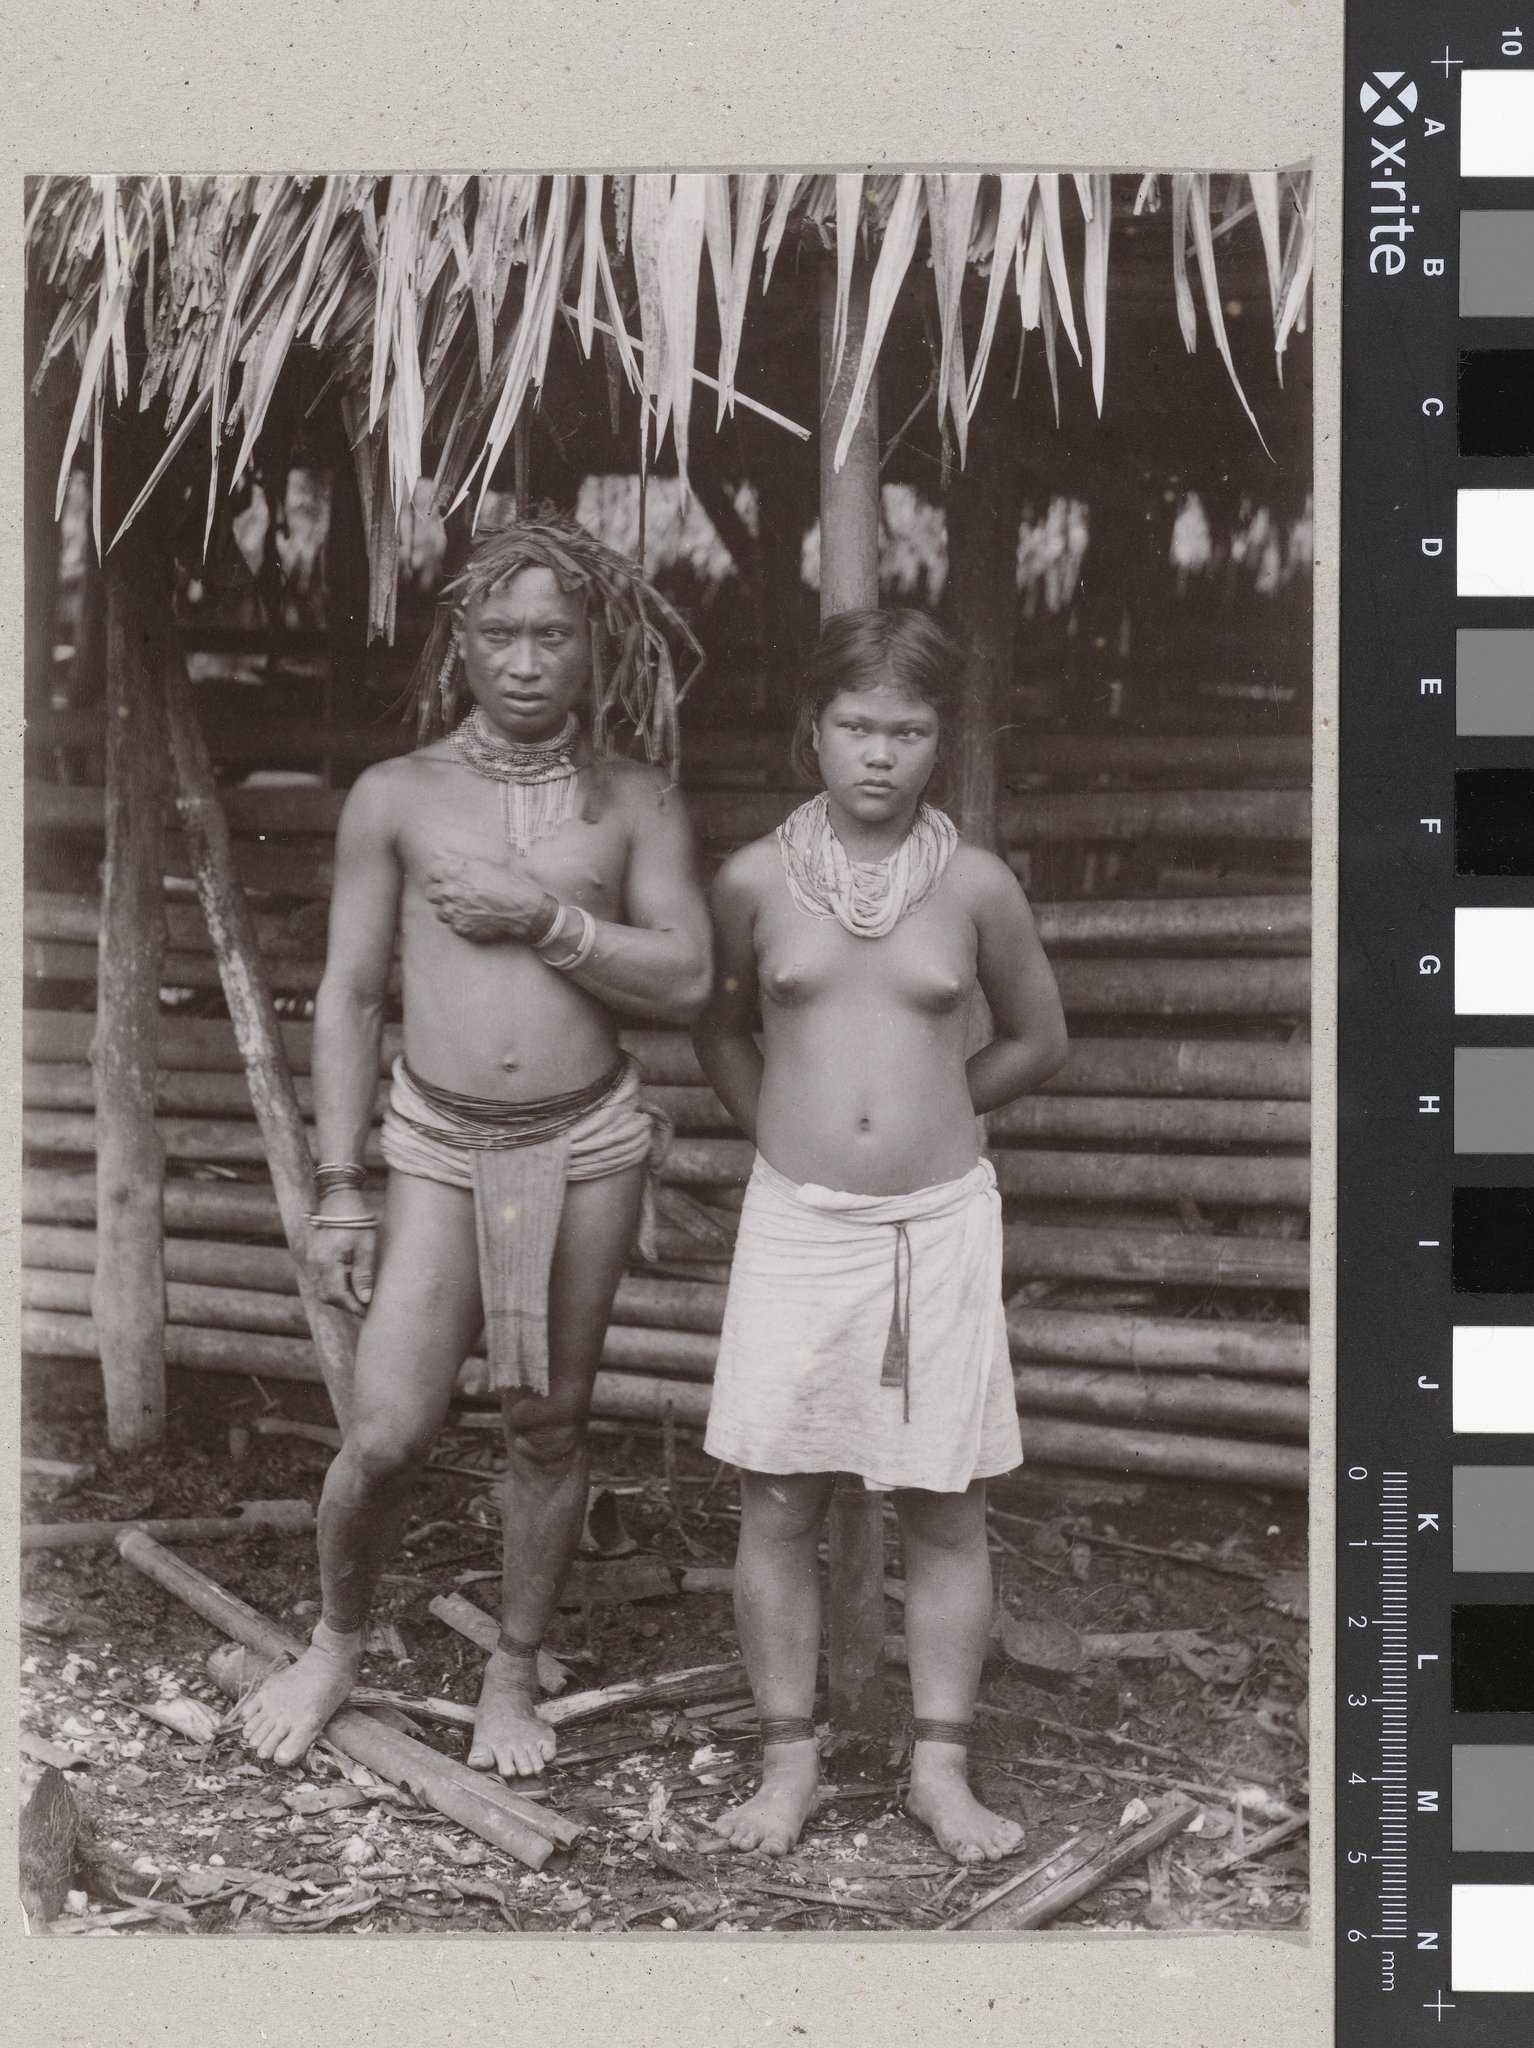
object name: photograph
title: Portret van een onbekende man en jonge vrouw op de Mentawei-eilanden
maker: christiaan benjamin nieuwenhuis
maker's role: publisher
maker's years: 1863-1922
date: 1890-1897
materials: paper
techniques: albumen print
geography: medan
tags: folk costume, regional costume, anonymous historical persons portrayed in a double portrait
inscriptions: title: ‘Pagei's echtpaar’